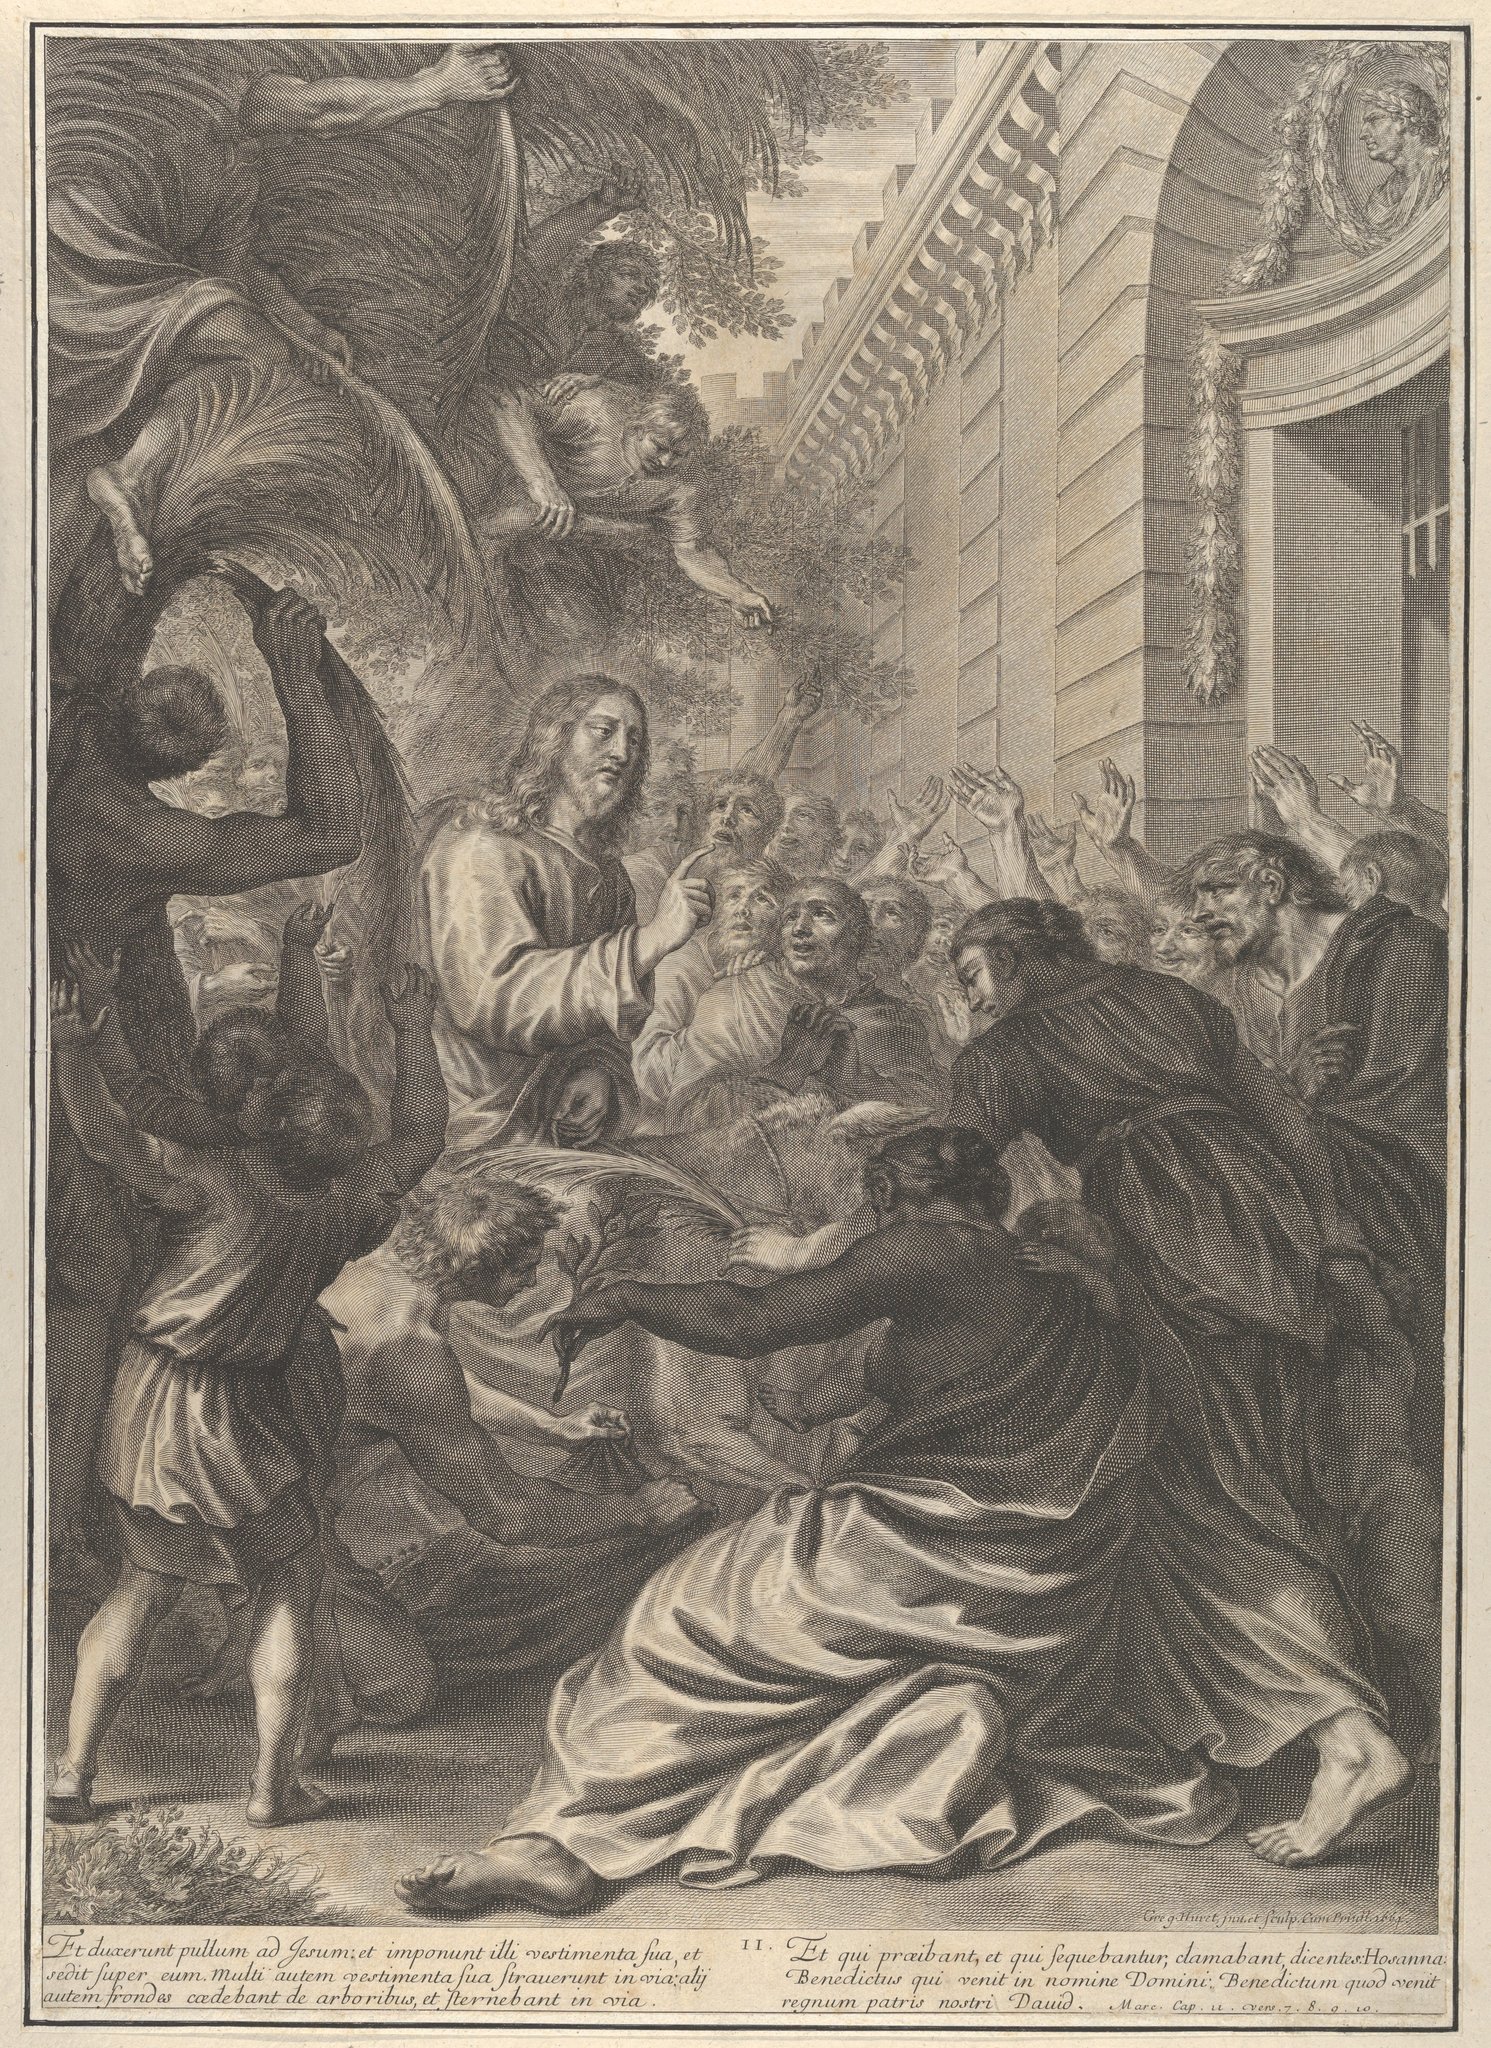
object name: print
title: Christ's Entrance into Jerusalem, from The Passion of Christ, plate 2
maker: grégoire huret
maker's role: artist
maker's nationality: french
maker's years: 1606-1670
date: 1664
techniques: engraving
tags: donkeys,christ,crowd